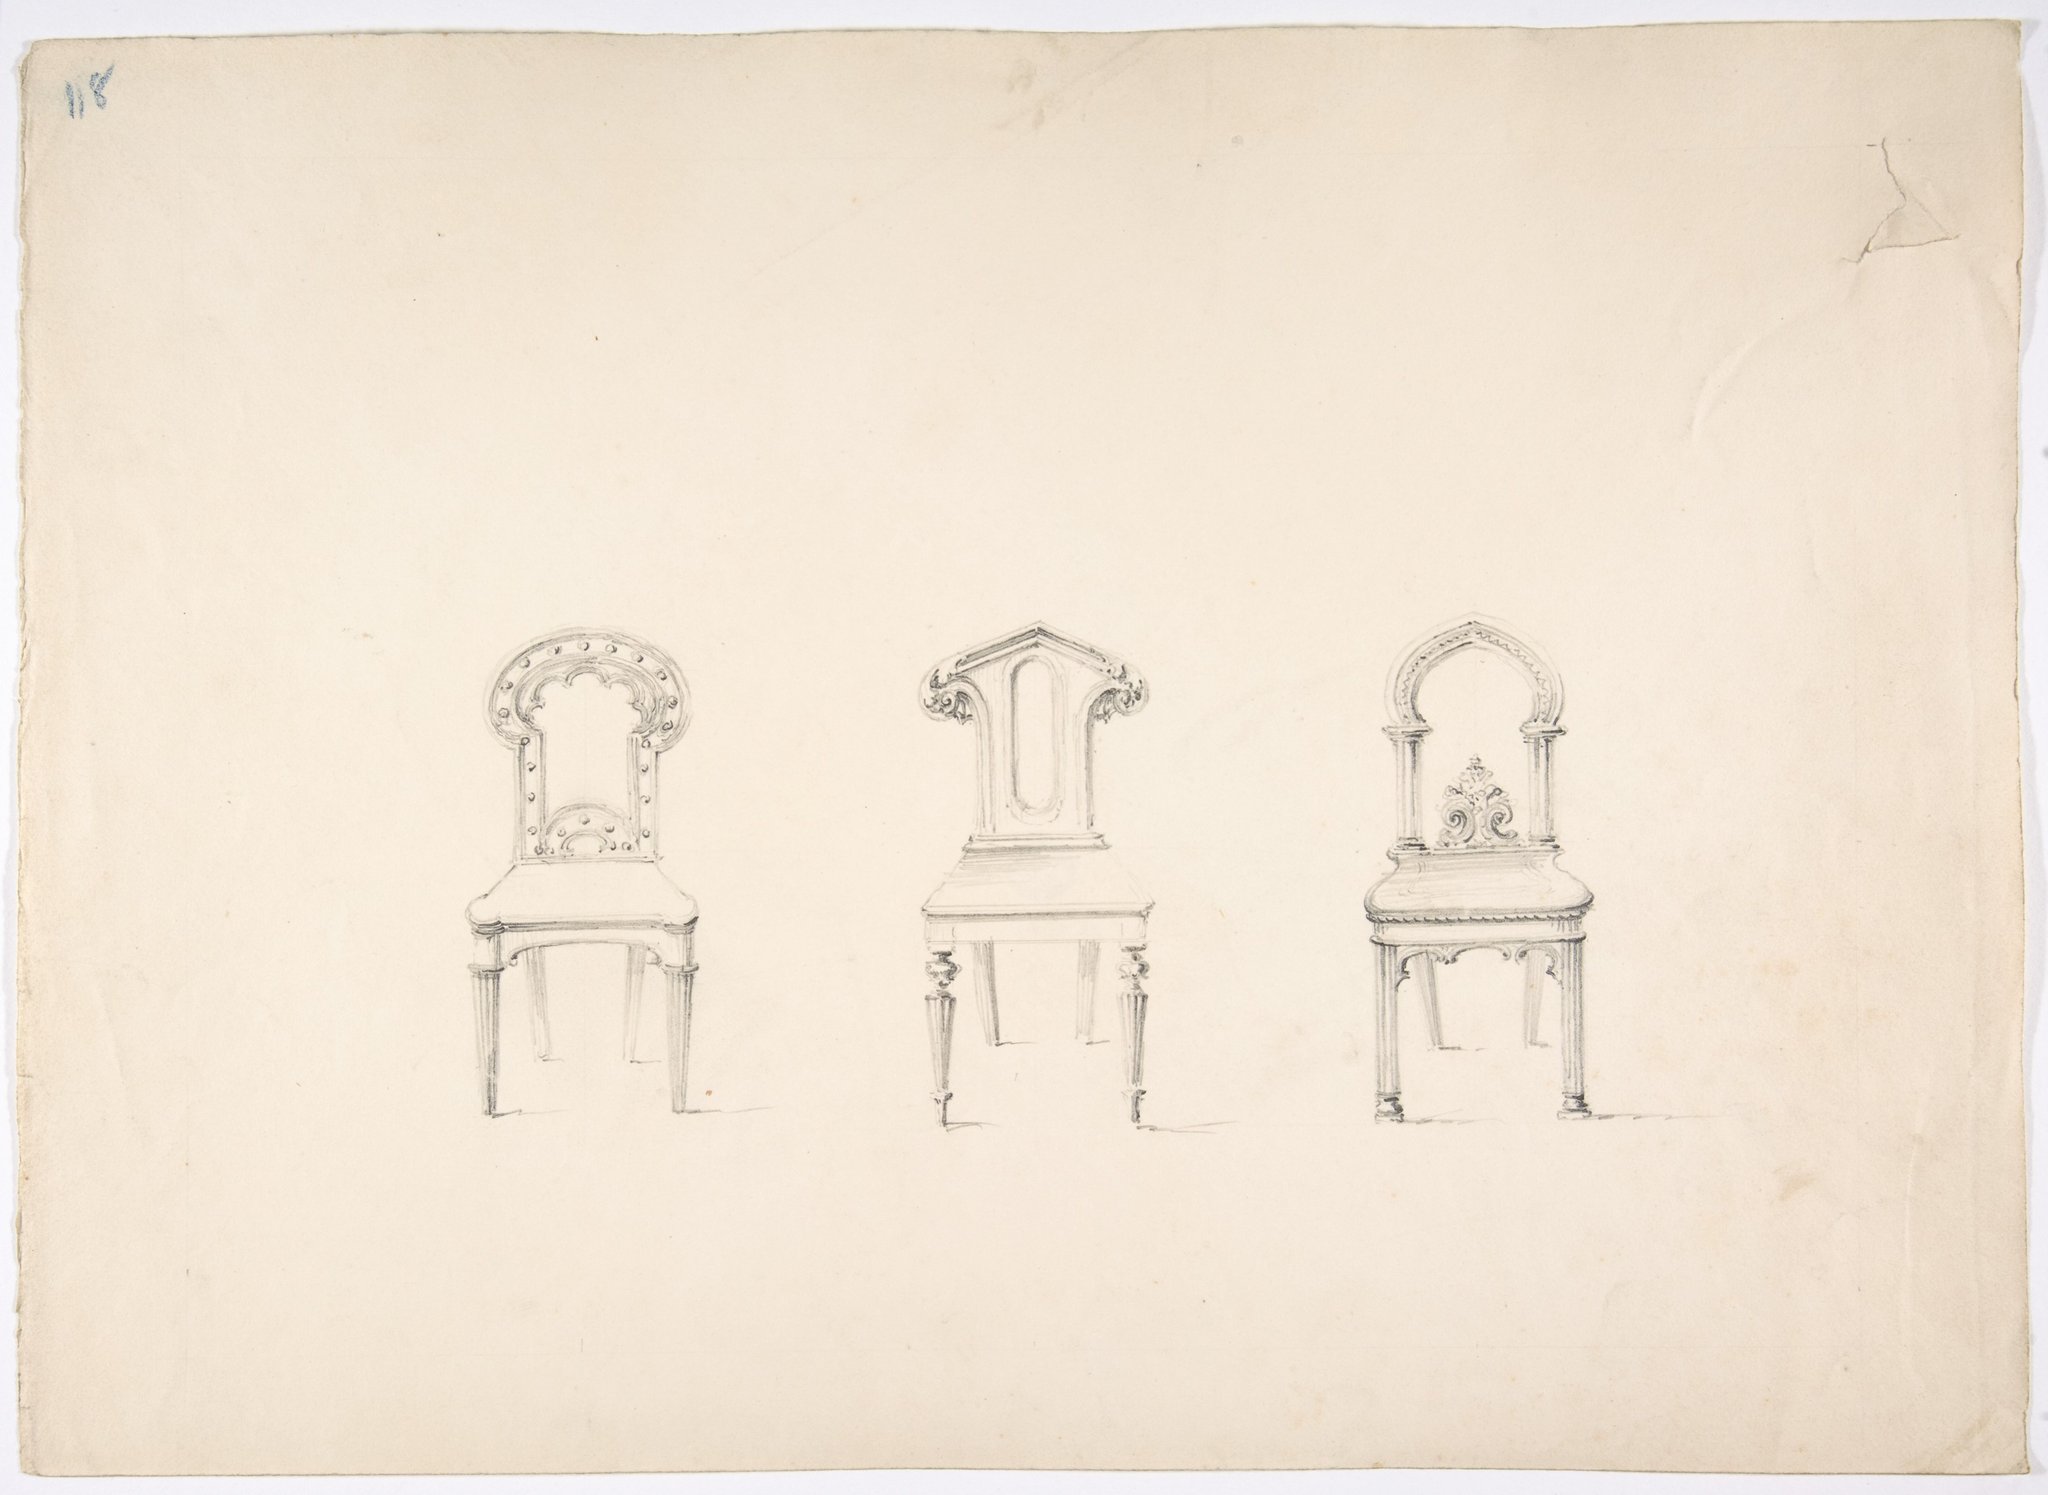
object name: drawing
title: Design for Three Chairs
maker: anonymous, british, 19th century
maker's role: artist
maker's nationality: british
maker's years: 1800-1900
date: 1801-1833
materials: graphite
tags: chairs